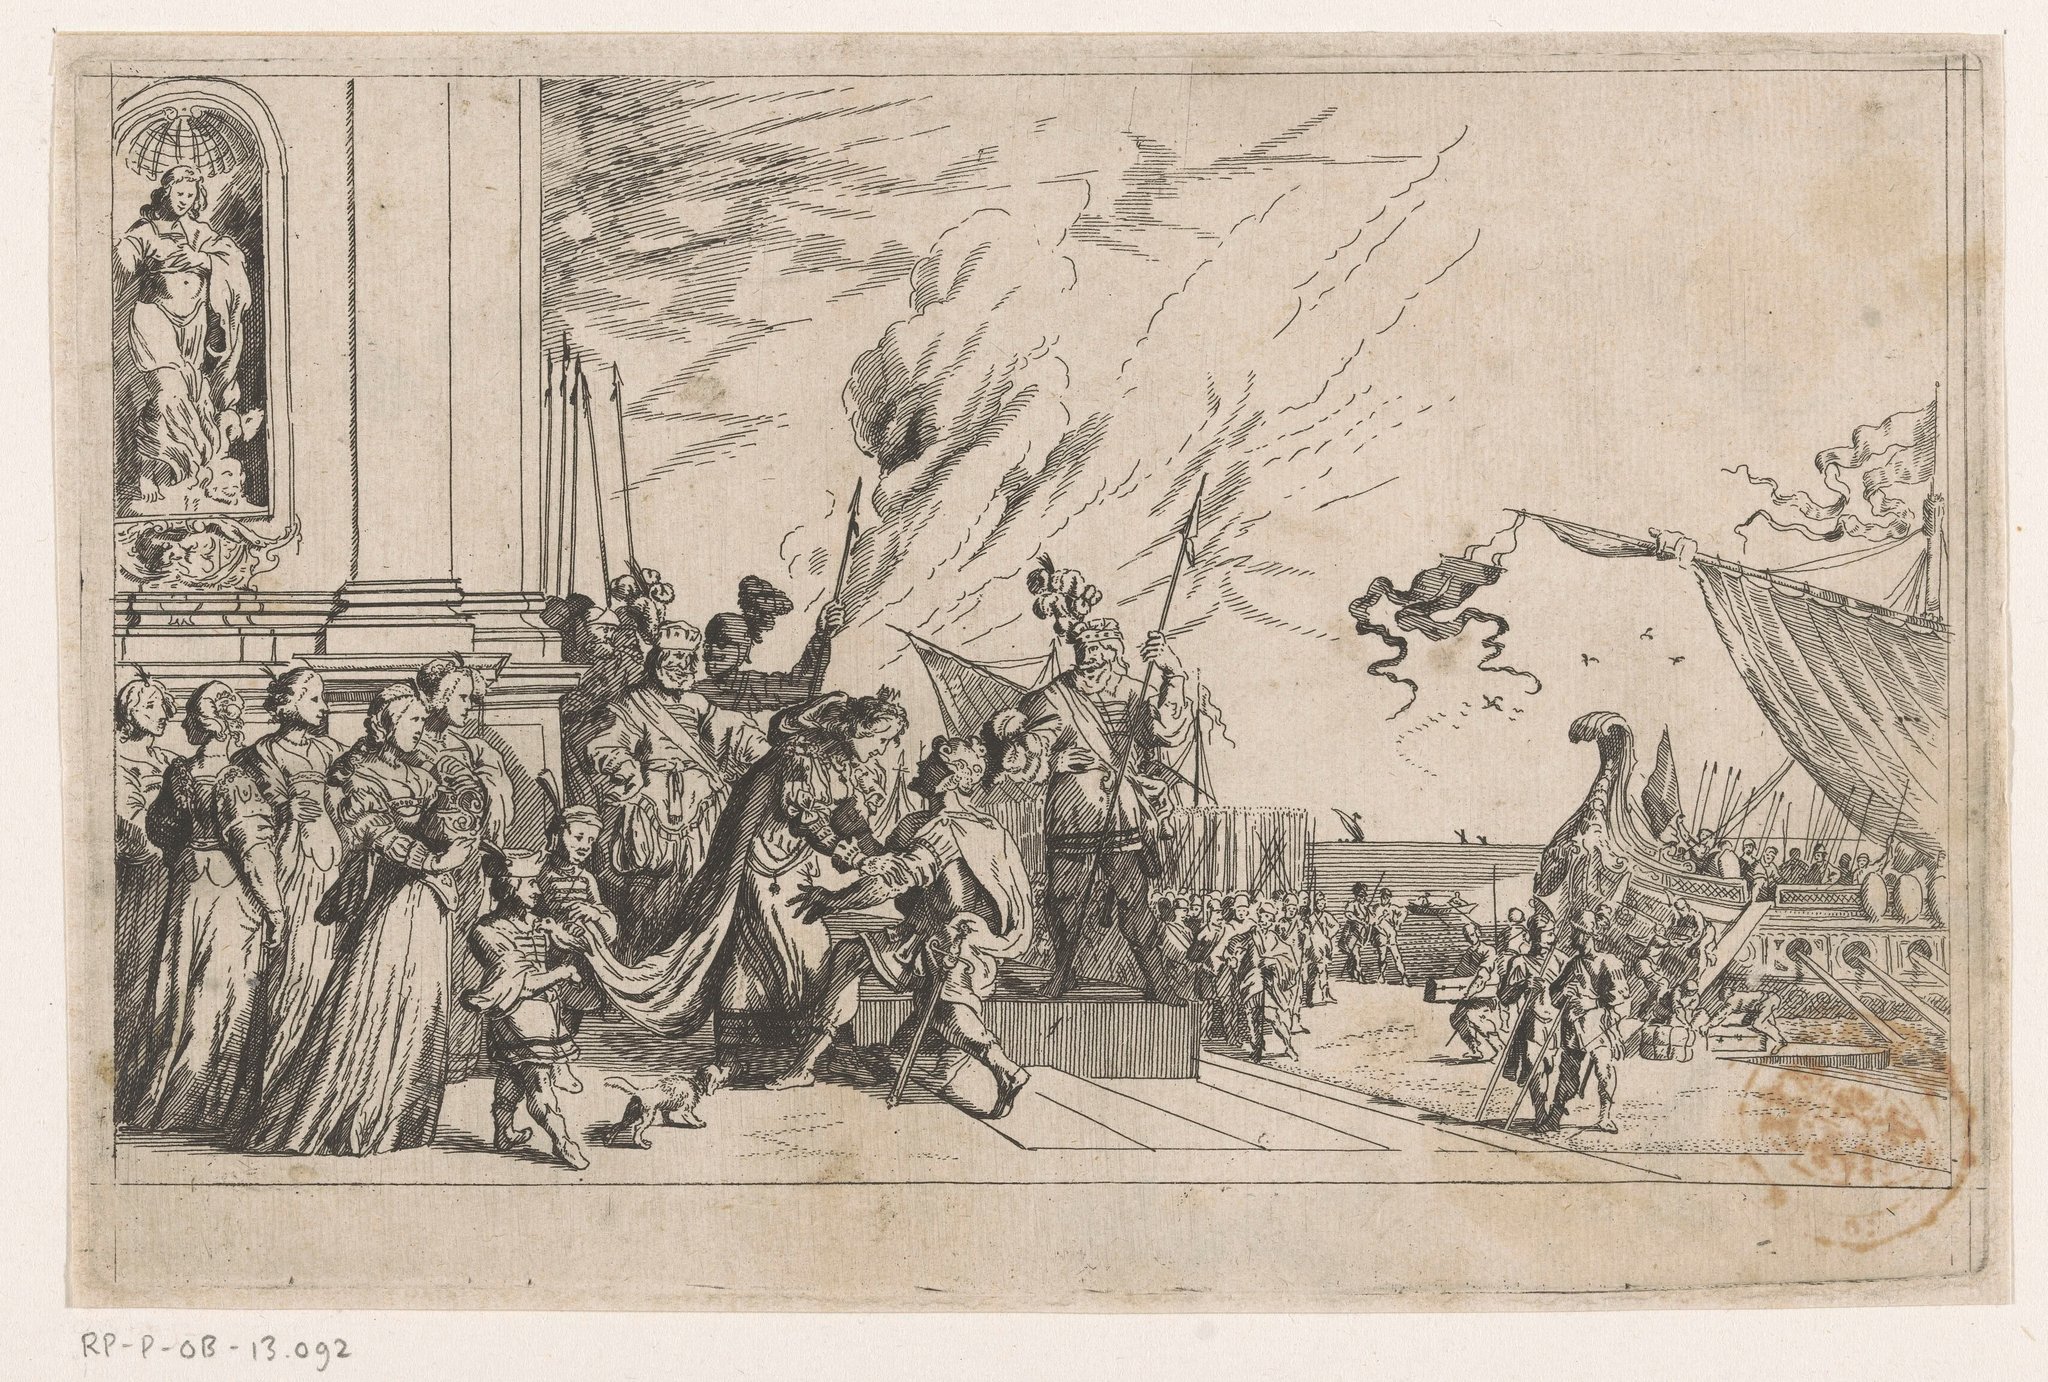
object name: print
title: Dido ontvangt Aeneas in Carthago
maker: Anonymous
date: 1639-1700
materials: paper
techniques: etching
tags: the meeting of aeneas and dido; when he approaches her throne, the cloud enveloping him and achates vanishes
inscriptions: collector's mark: Lugt 240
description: Anonieme kopie naar een prent uit de serie 'Metamorfosen van Ovidius', bestaand uit 150 prenten en een titelprent, uitgegeven tussen 1639-1641.